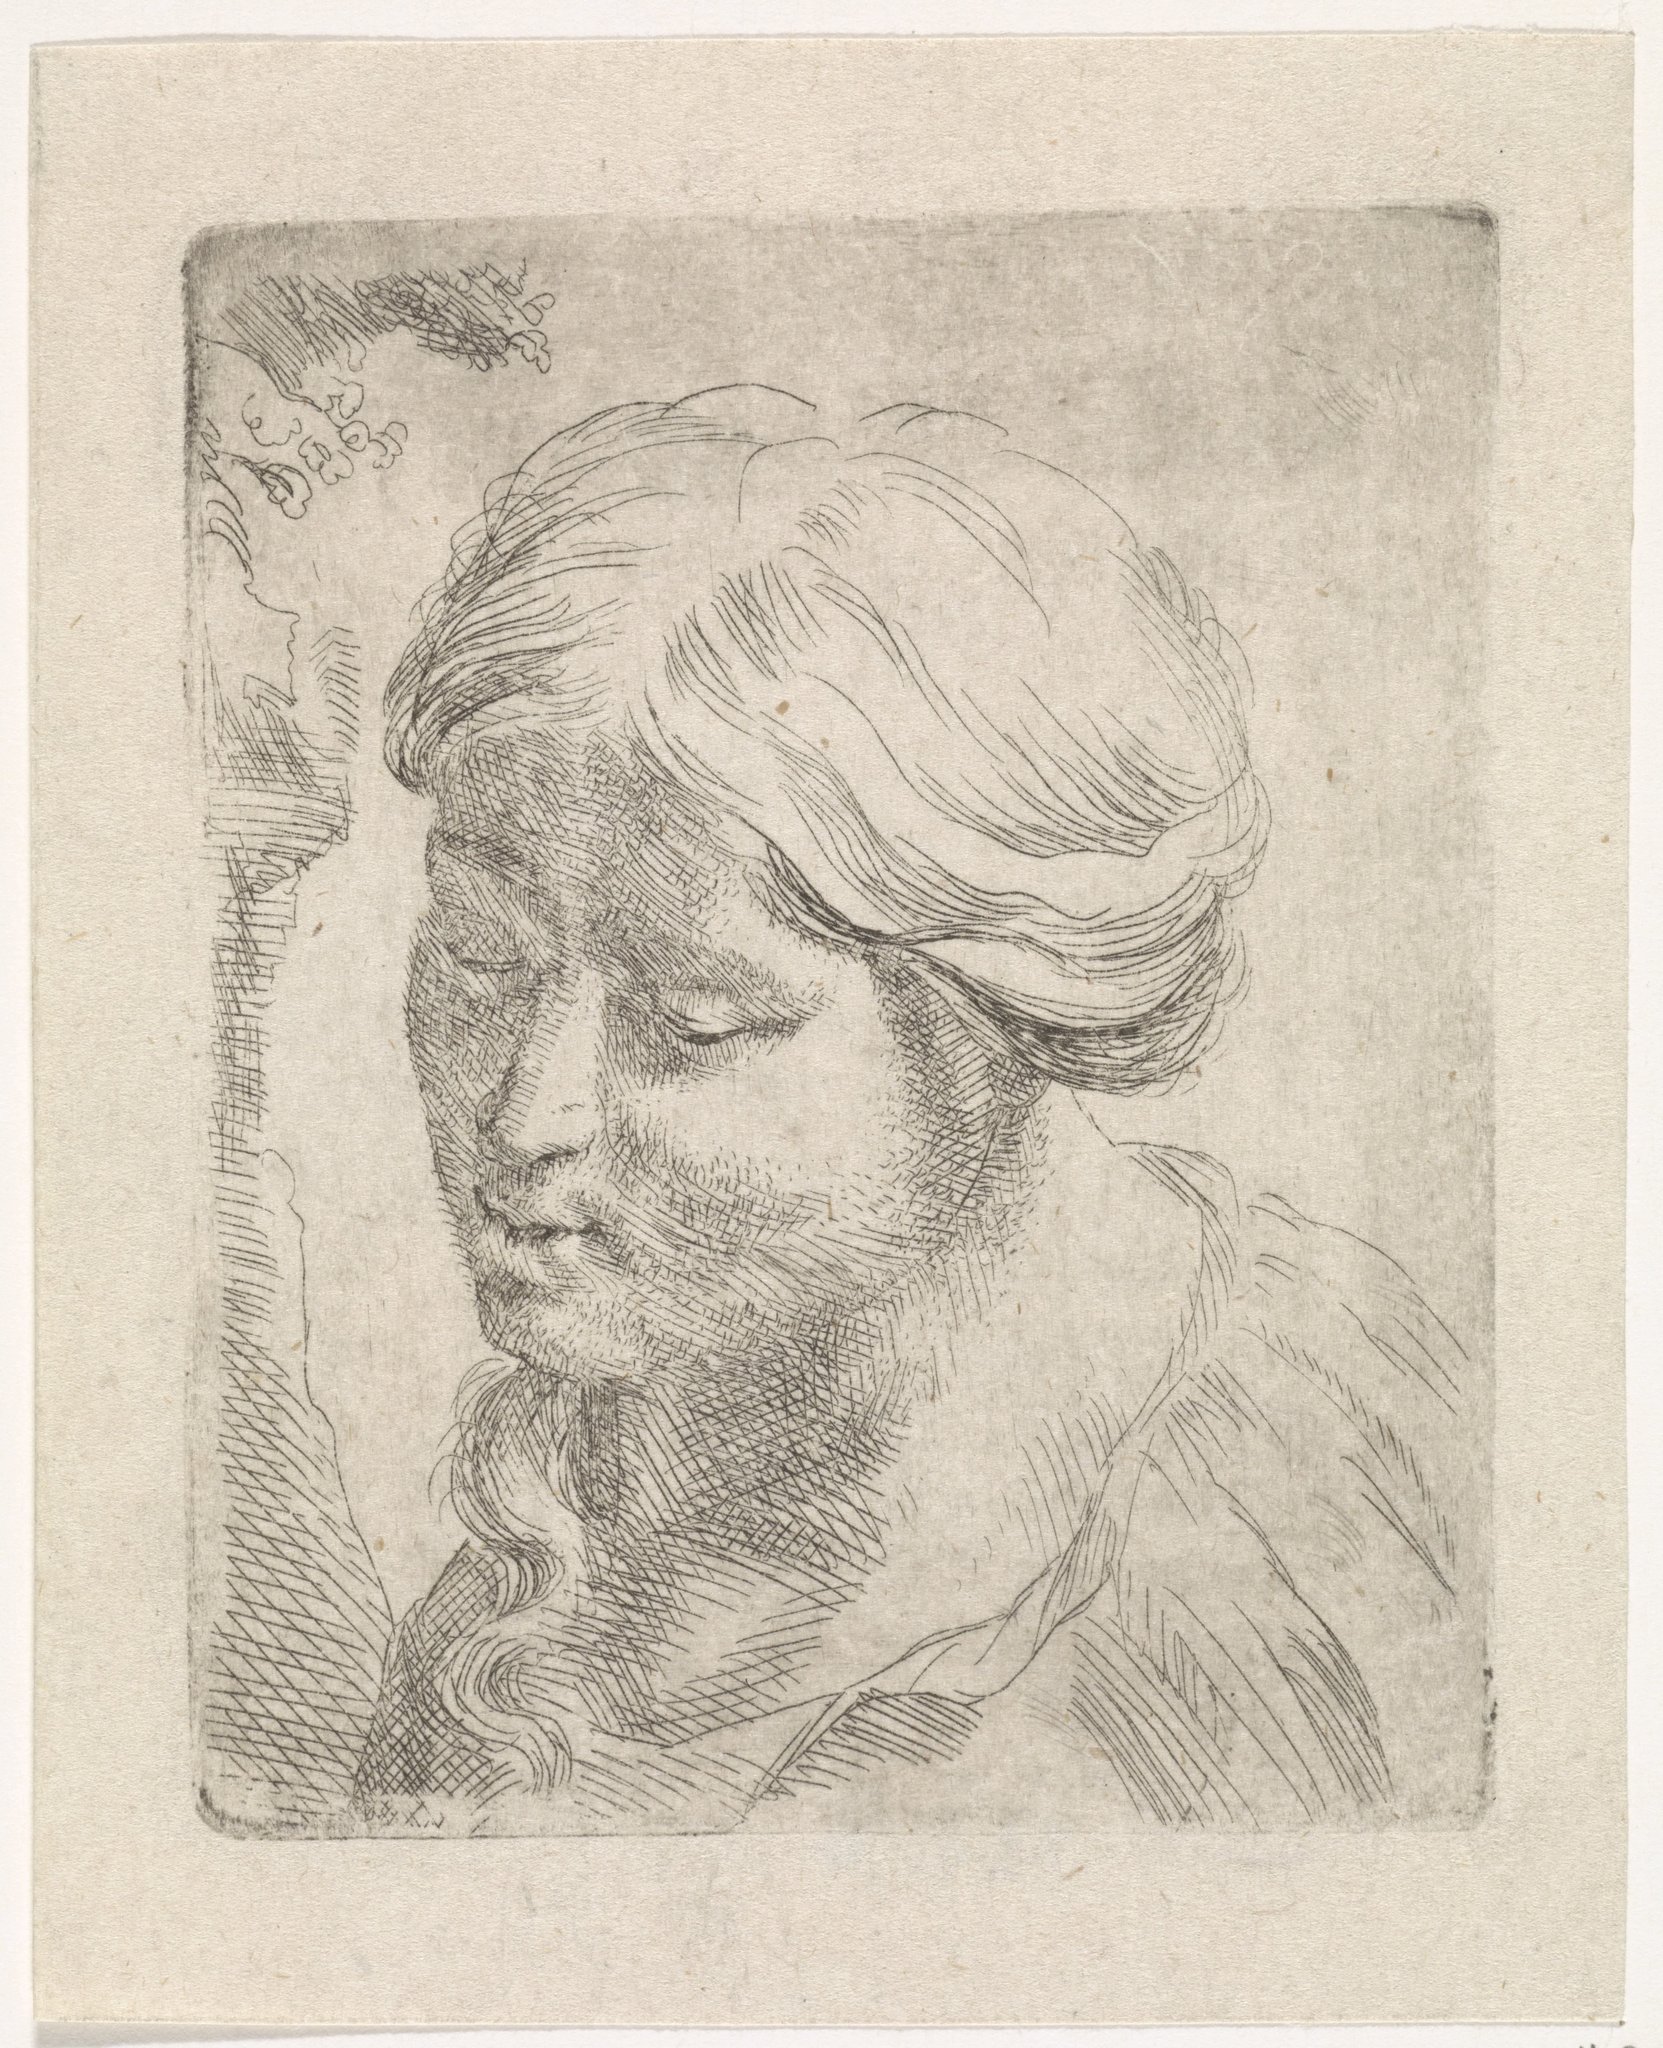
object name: print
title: Vrouw met lang haar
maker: carel de moor (ii)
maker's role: draughtsman, painter, print maker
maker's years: 1655-1738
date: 1665-1738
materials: paper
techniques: etching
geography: netherlands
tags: adult woman, eyes closed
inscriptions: collector's mark: Lugt 240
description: Een vrouw met neergeslagen ogen. Over haar rechterschouder hangt een haarlok.